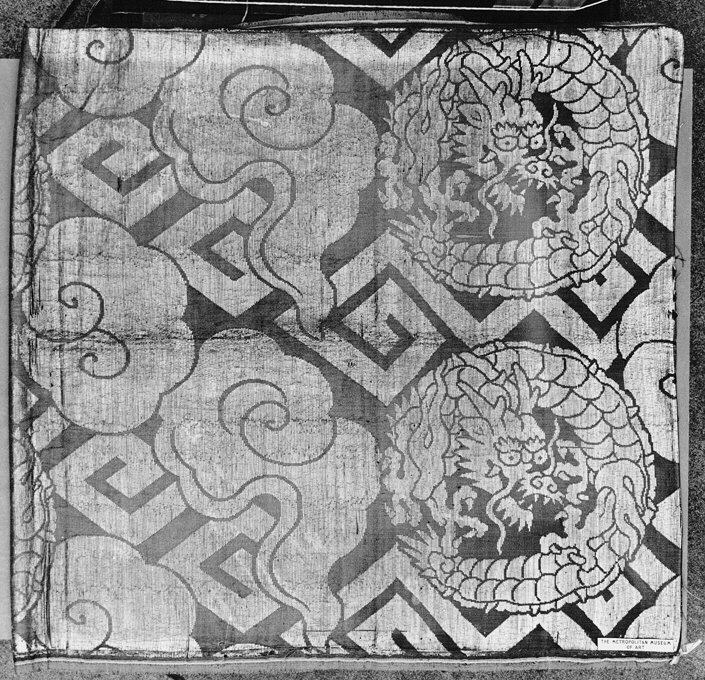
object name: piece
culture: japanese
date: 1701-1800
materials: silk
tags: dragons